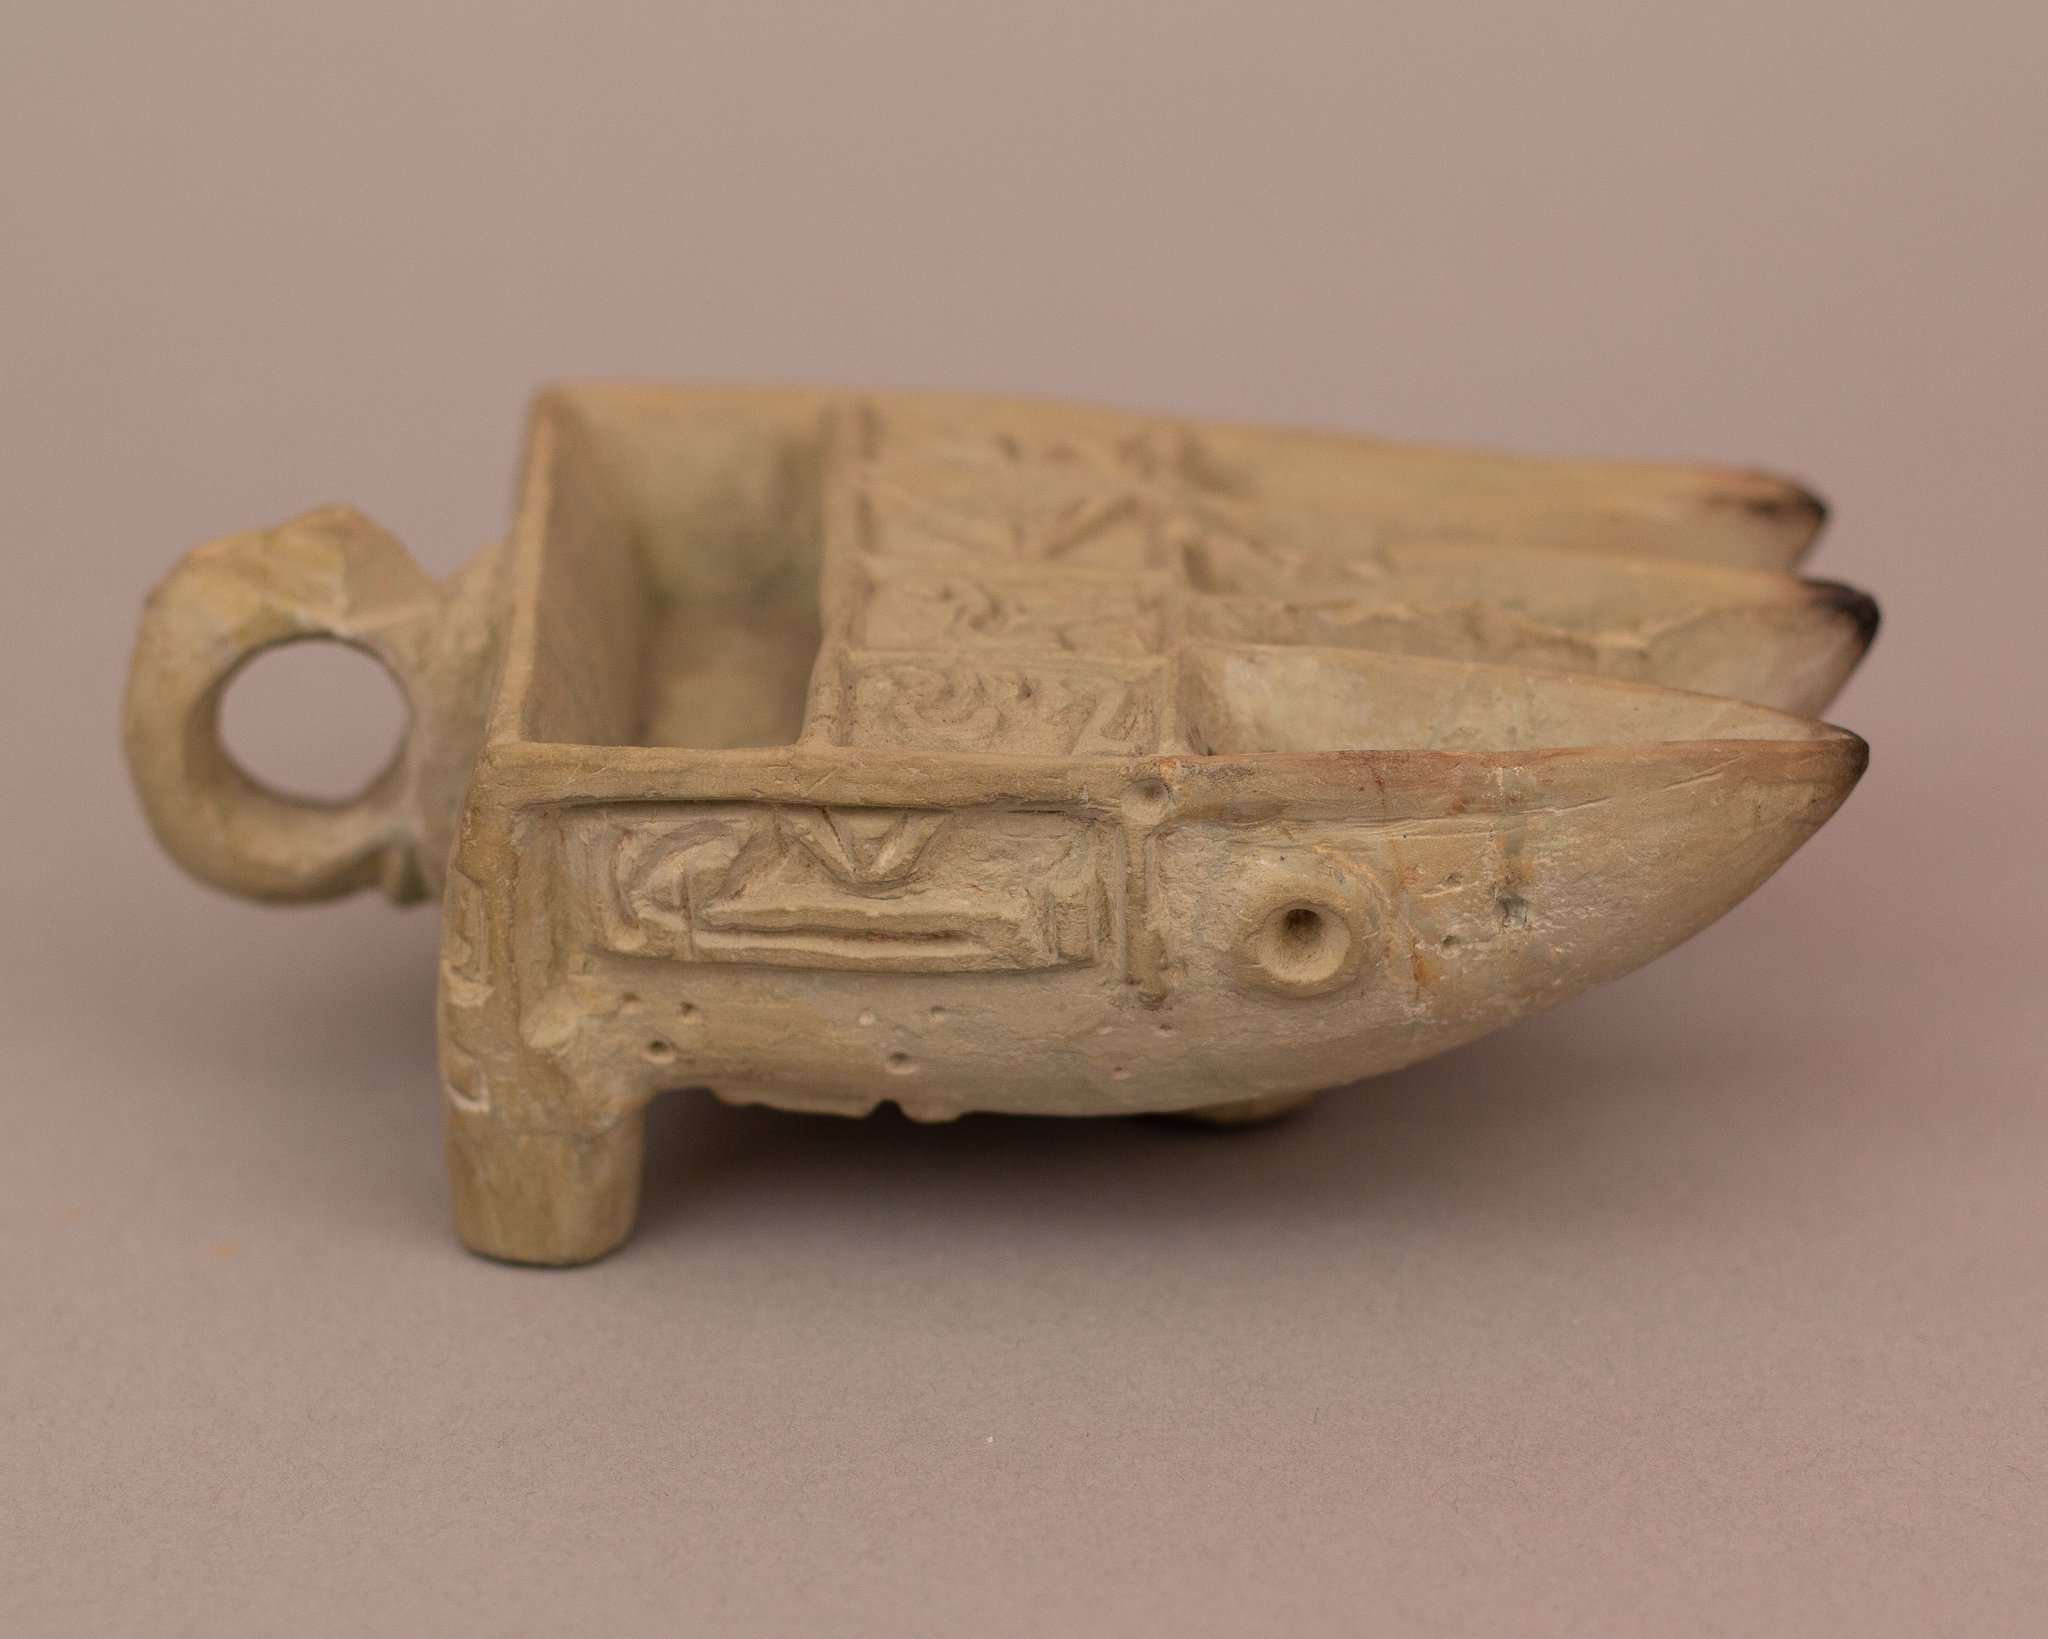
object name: lamp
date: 801-1000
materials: stone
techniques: carving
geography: iraq